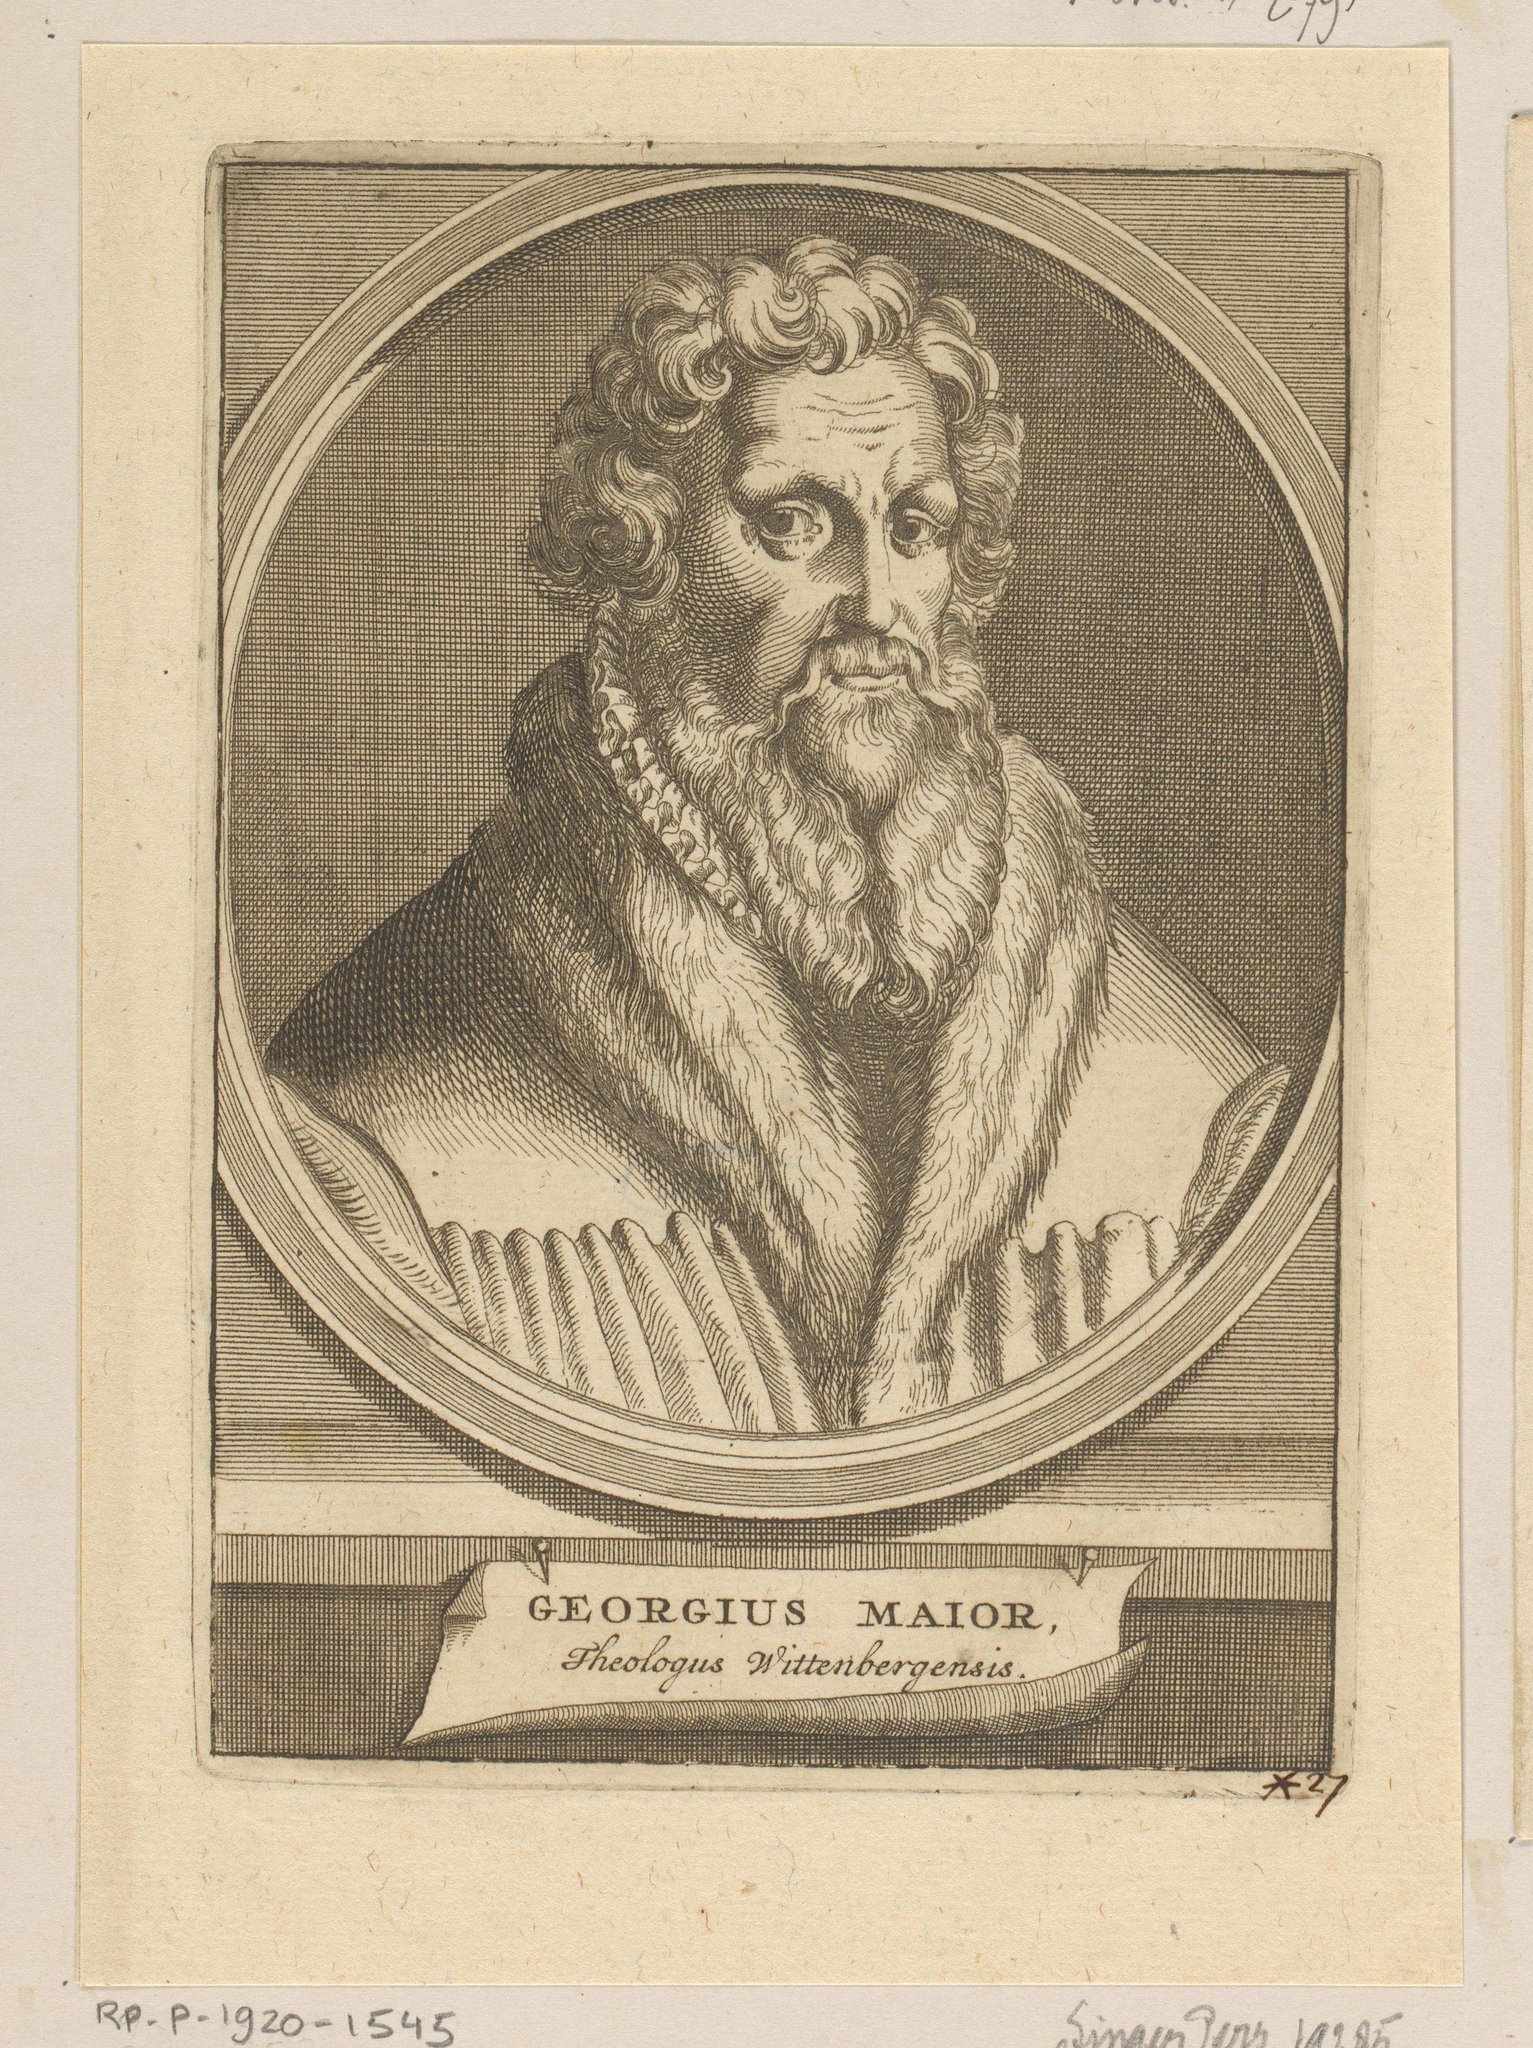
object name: print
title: Georgius Maior theologus Wittenbergensis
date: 1610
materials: paper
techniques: engraving, etching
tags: theologian, historical persons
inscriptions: inscription: ‘*27’, collector's mark: Lugt 2228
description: Eerste staat van de prent verschenen in: Effigies praestant aliquot virorum qui veram in primis religion nostro seculo propagarunt. Den Haag: Hendrick Hondius, [ca. 1610].